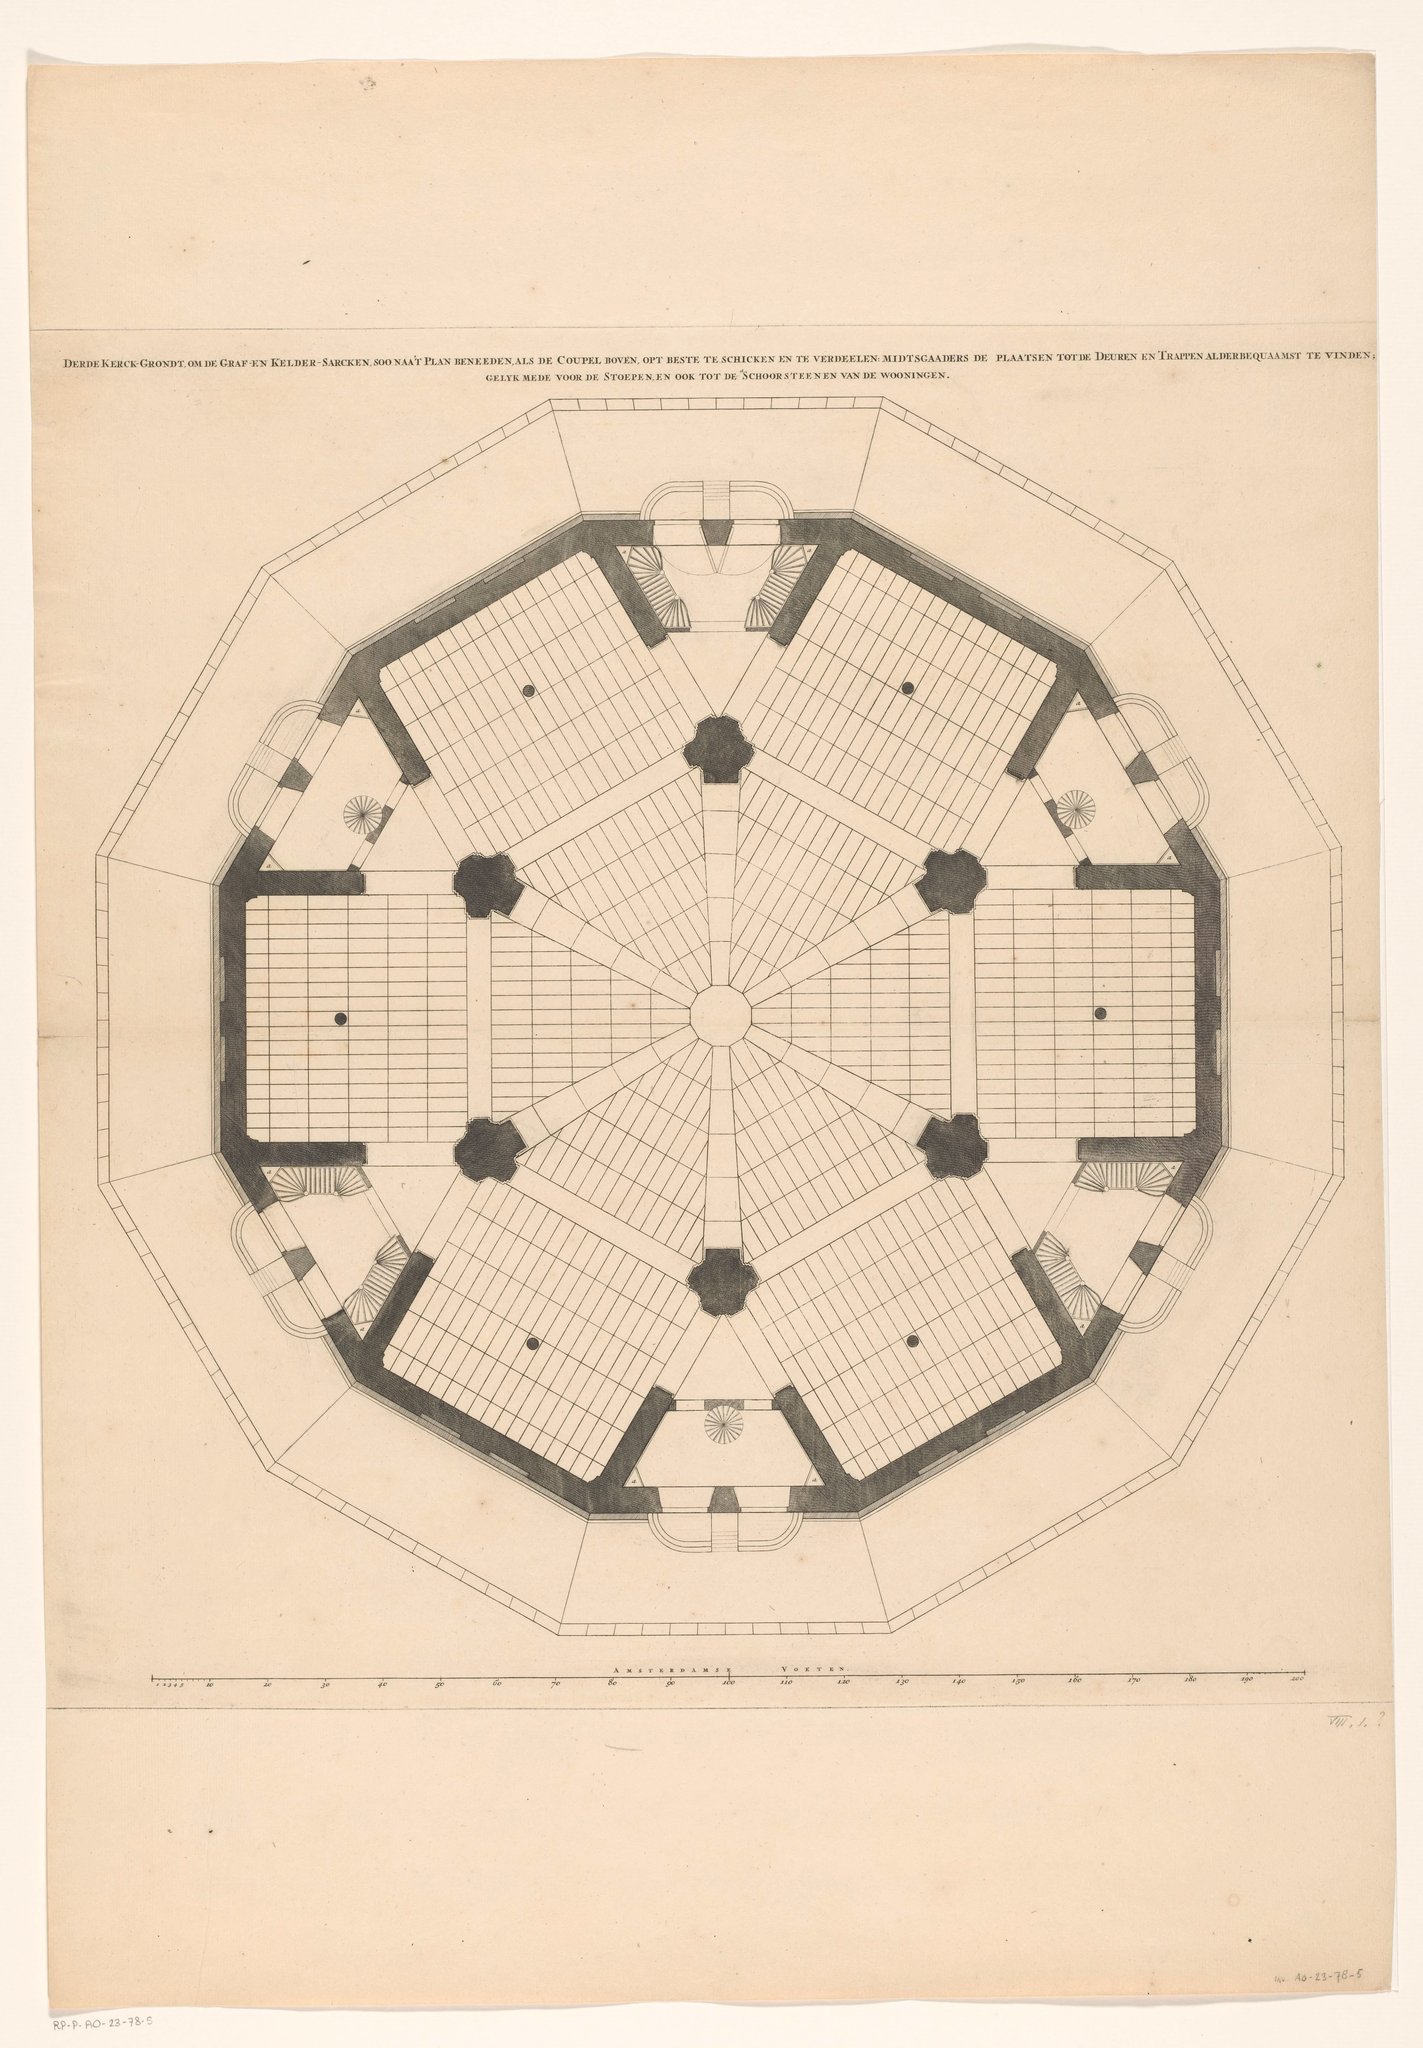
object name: area plan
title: Nieuw ontwerp voor een koepelkerk op de Botermarkt te Amsterdam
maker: daniël stopendaal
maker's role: print maker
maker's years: 1672-1726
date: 1700-1705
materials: paper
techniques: engraving, etching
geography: amsterdam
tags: church (exterior), interior of church, plan ~ architecture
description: Notaris, advocaat en kerkmeester van de Oude Kerk Nicolaas Listingh maakte rond 1700 een ontwerp voor een nieuwe koepelkerk op de Botermarkt (het huidige Rembrandtplein). Naast een houten maquette, die nog steeds te zien is in de Oude Kerk, liet hij ook op eigen kosten een serie van zeventien prenten van zijn ontwerp maken ('Nievv desseyn tot een Seer Groote, Stercke, en om te hooren, heel bequame Coupel-Kerck (…)'). De huidige prent is daar onderdeel van. Deze prenten zouden zijn gemaakt door Daniël Stopendaal.* *Long, Isaac le. Historische beschryvinge van de reformatie der stadt Amsterdam (…). Amsterdam: Johannes van Septeren (I), 1729, p. 572.